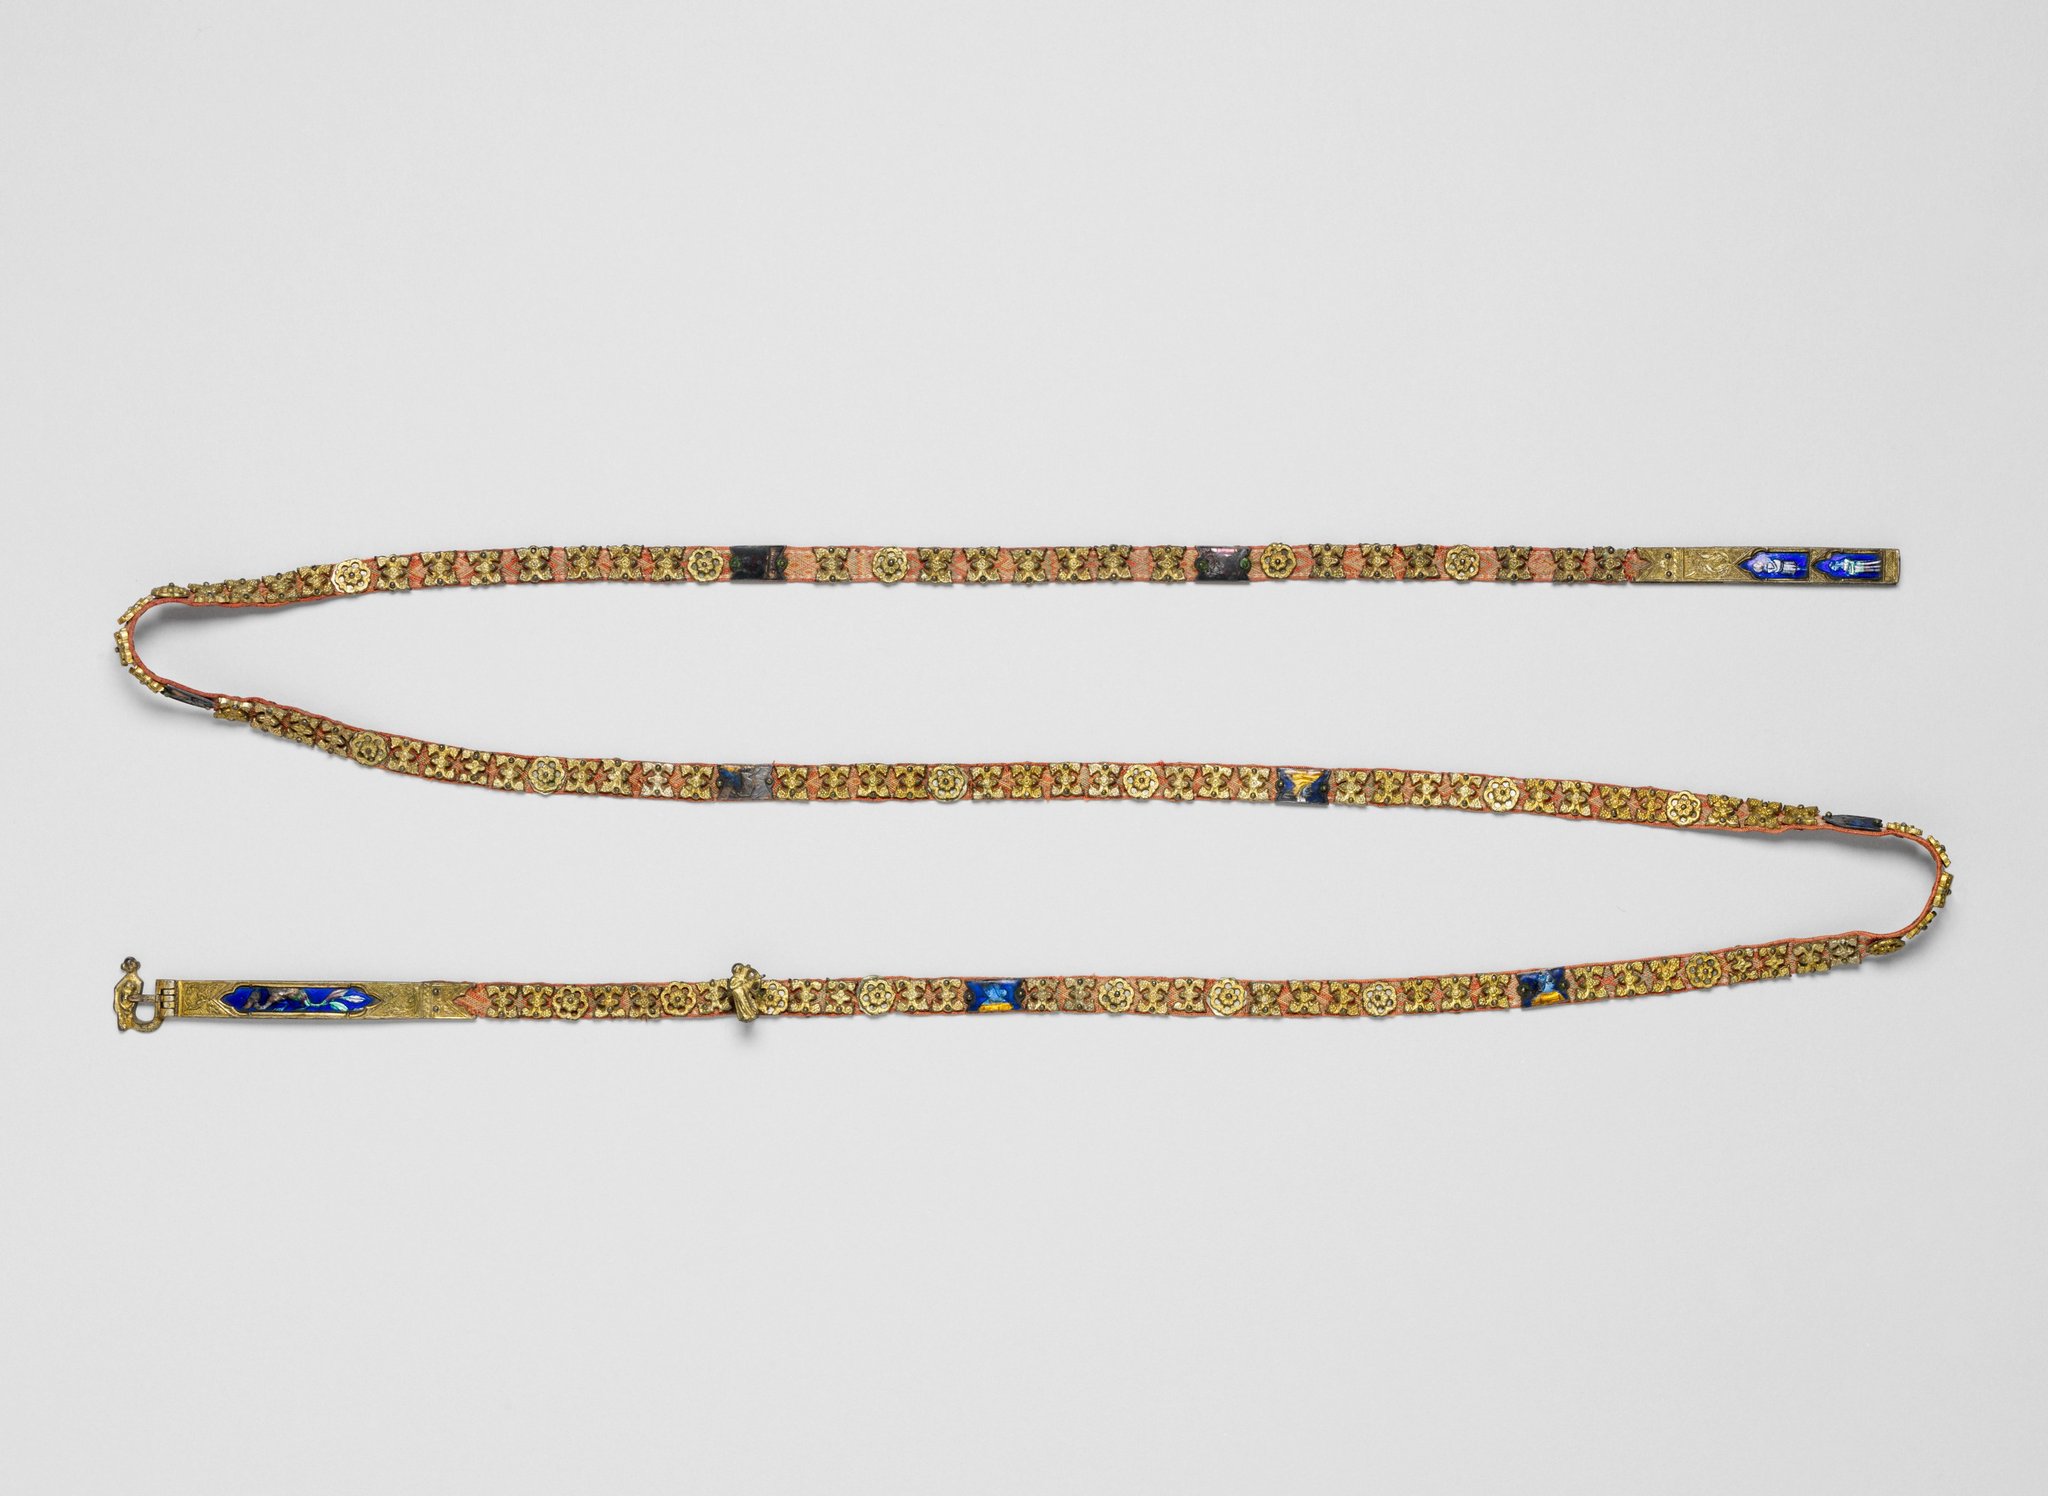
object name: belt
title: Belt with Profiles of Half-Length Figures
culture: italian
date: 1350-1400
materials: enamel, silver gilt, textile